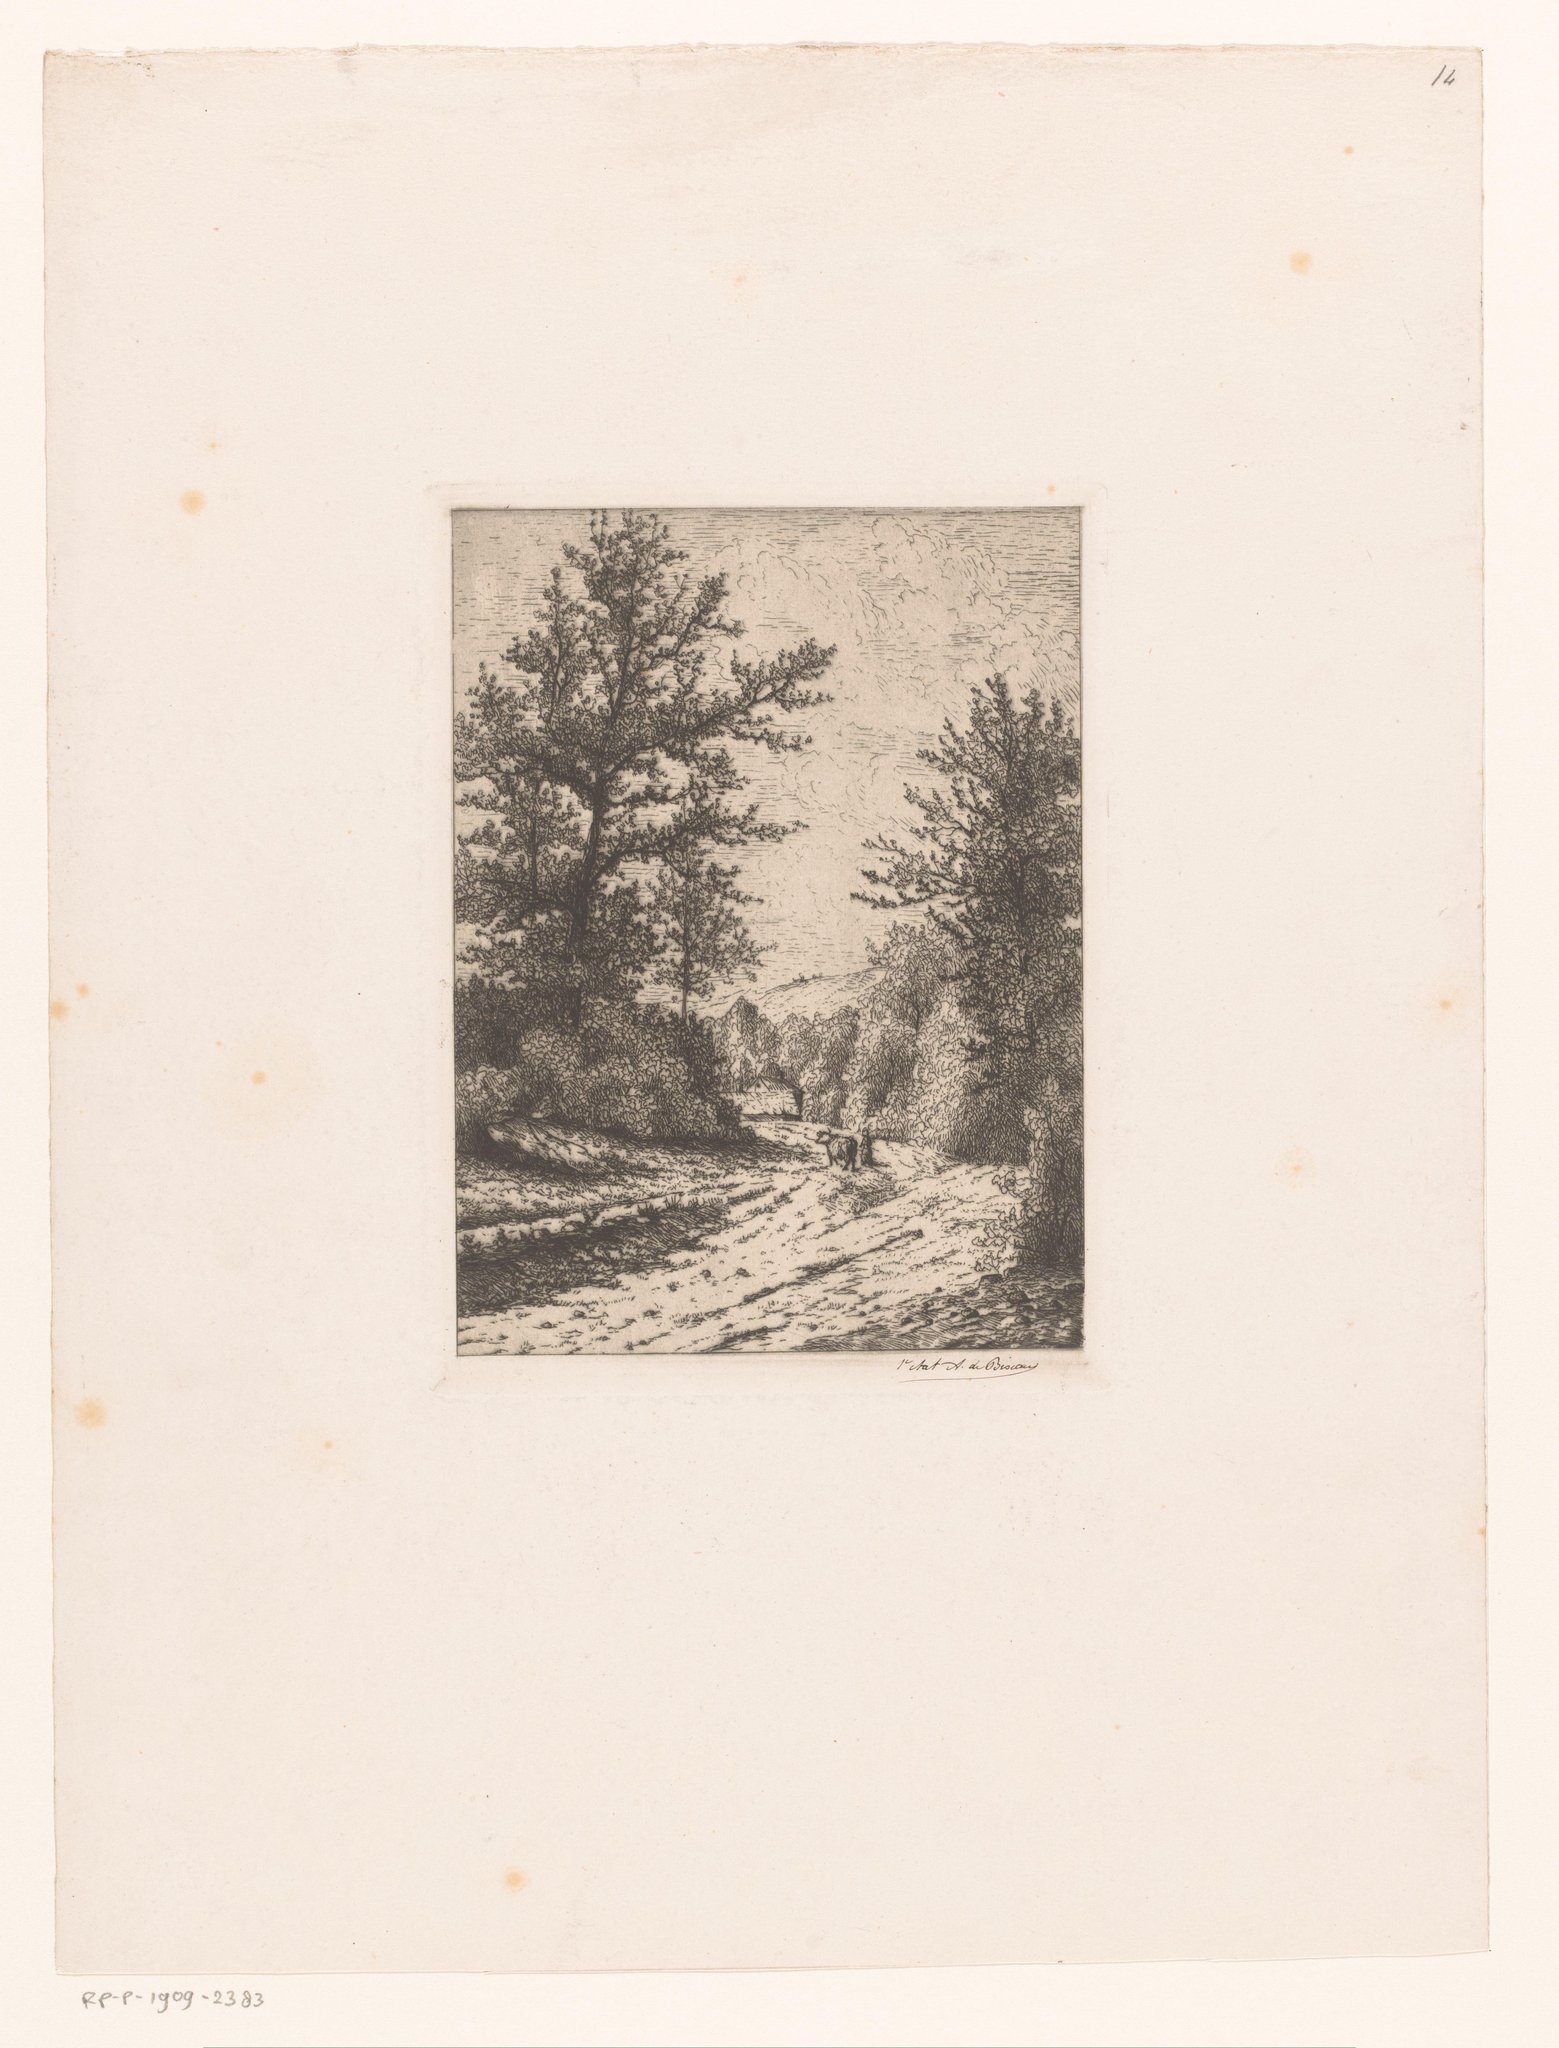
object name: print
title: Landschap met vrouw en koe op een pad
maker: aristide de biseau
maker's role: print maker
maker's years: 1844-1883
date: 1854-1883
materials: paper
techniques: drypoint, etching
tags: cow, landscapes, farm or solitary house in landscape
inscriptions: collector's mark: Lugt 2228